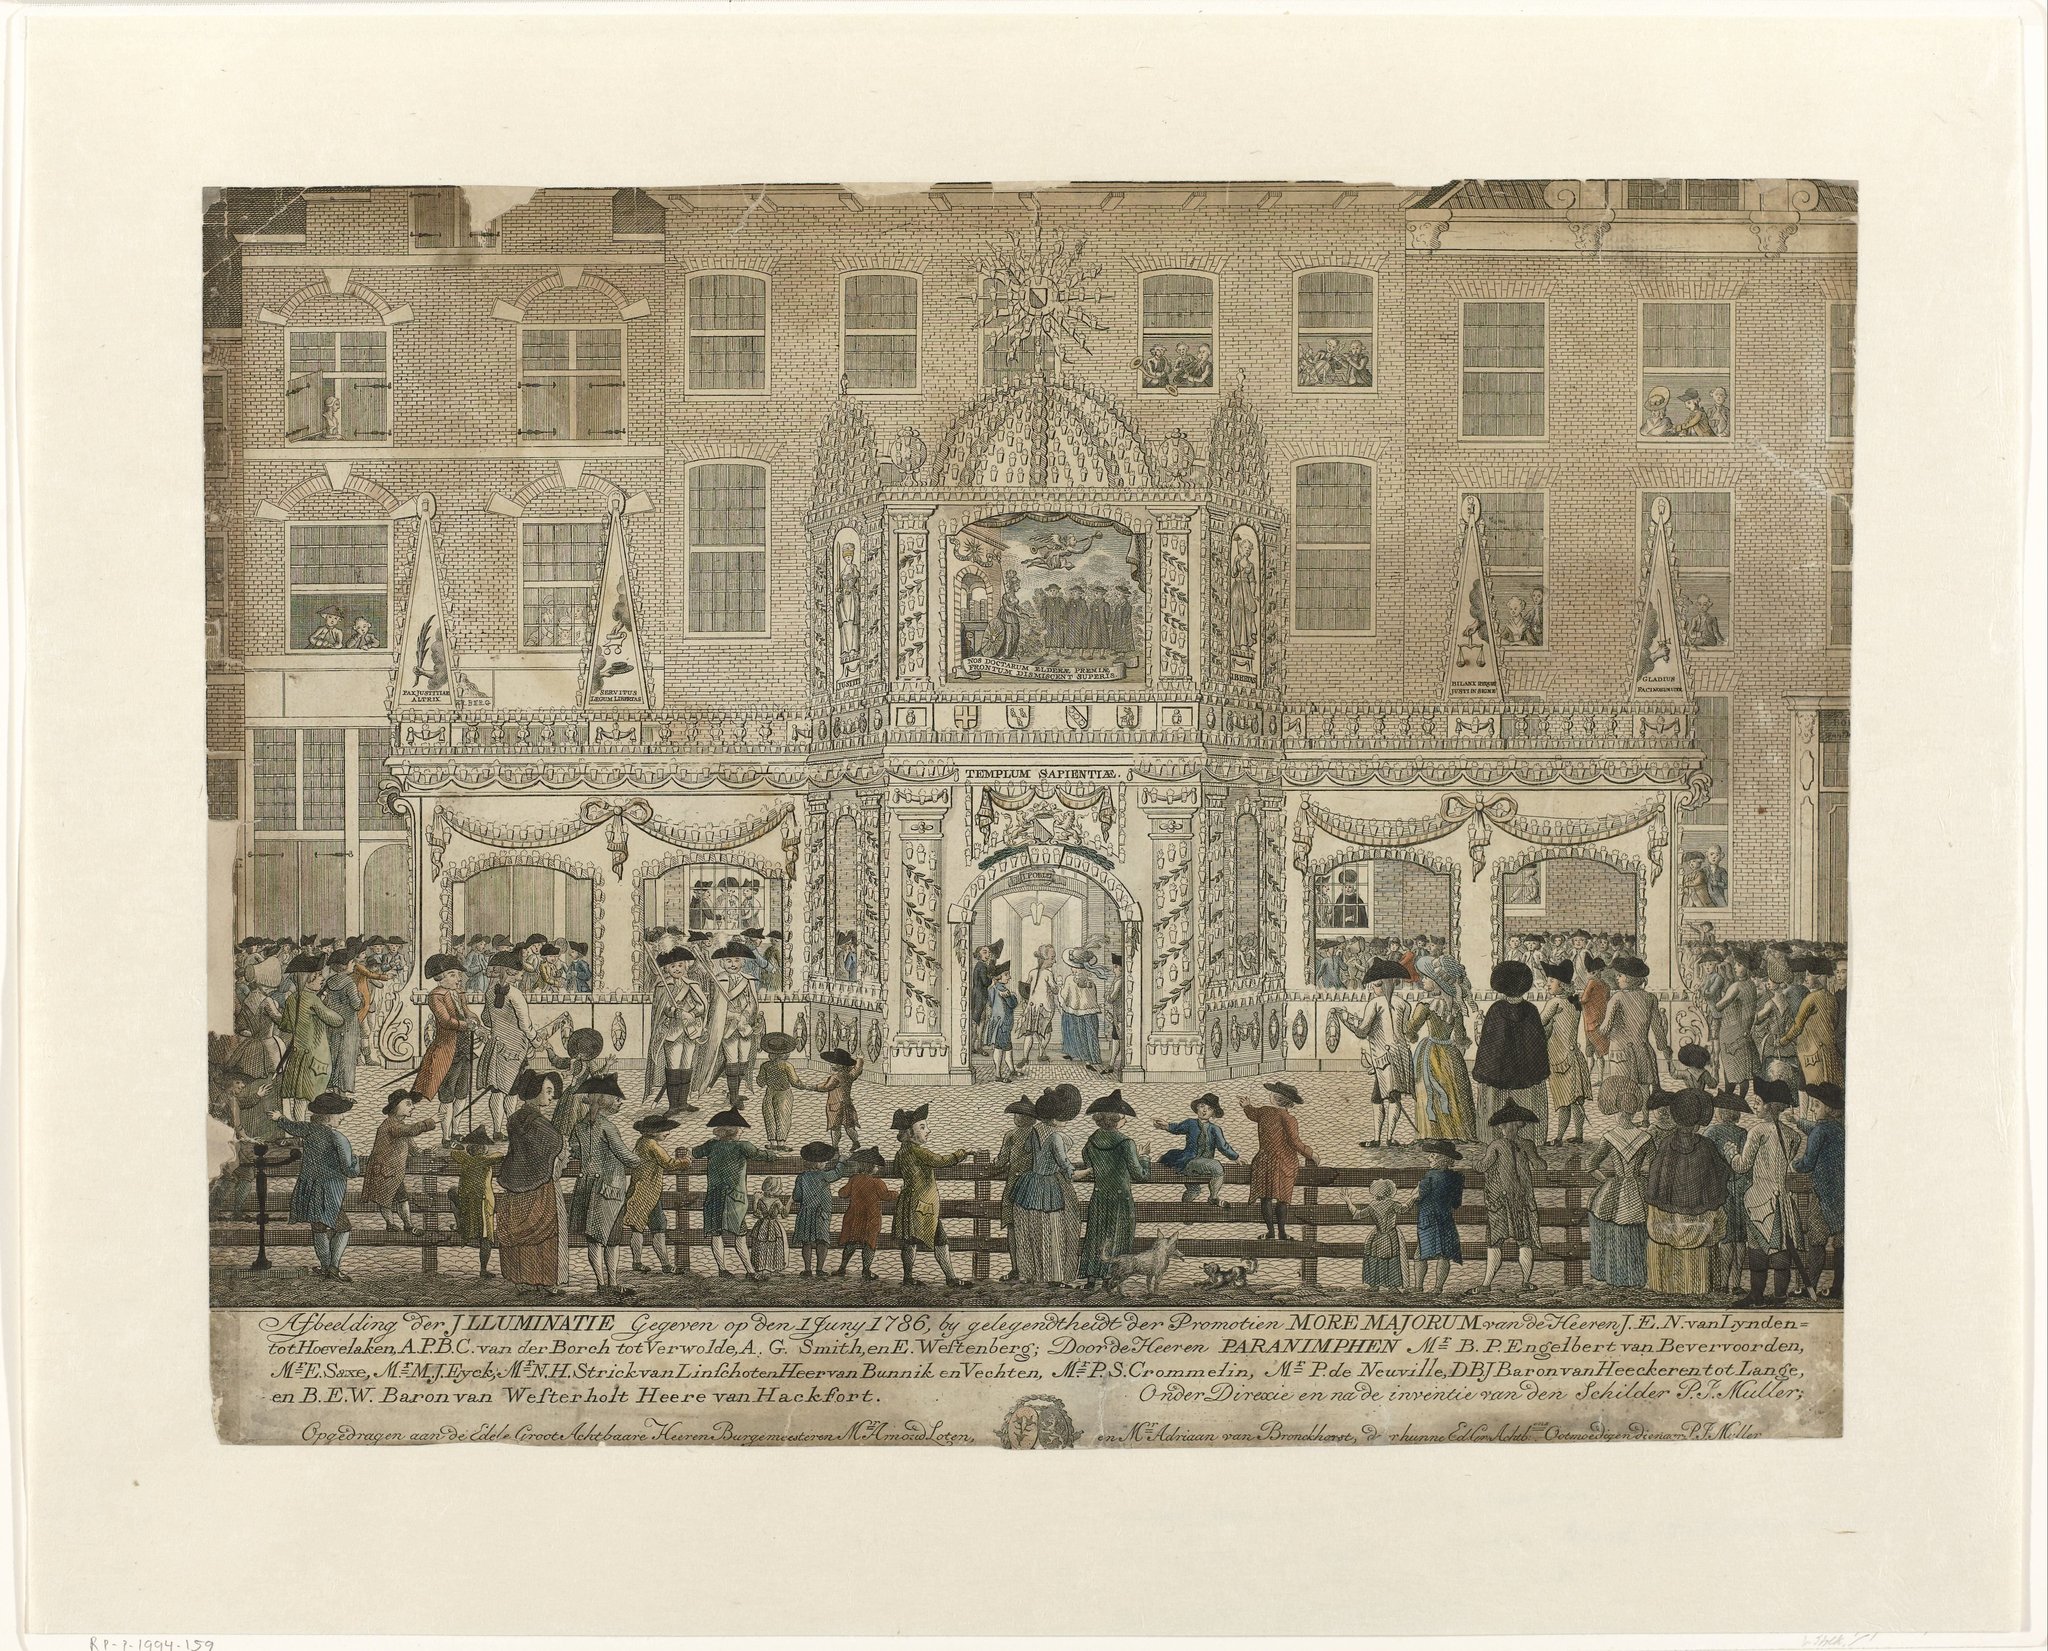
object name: print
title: Illuminatie aangericht bij de promotie van enkele studenten te Utrecht, 1786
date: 1786-1787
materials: paper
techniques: engraving, etching, hand coloring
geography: northern netherlands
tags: receiving doctor's degree, rejoicing on special occasions (+ illumination, fire-works ~ festive activities), utrecht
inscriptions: collector's mark: Lugt 2228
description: Illuminatie van een gevel van een huis, ter gelegenheid van de promotie van de studenten J.E.N. van Lynden tot Hoevelaken, A.P.B.C. van der Borch tot Verwolde, A.G. Smith, en E. Westenberg, aan de Universiteit Utrecht op 1 juni 1786.